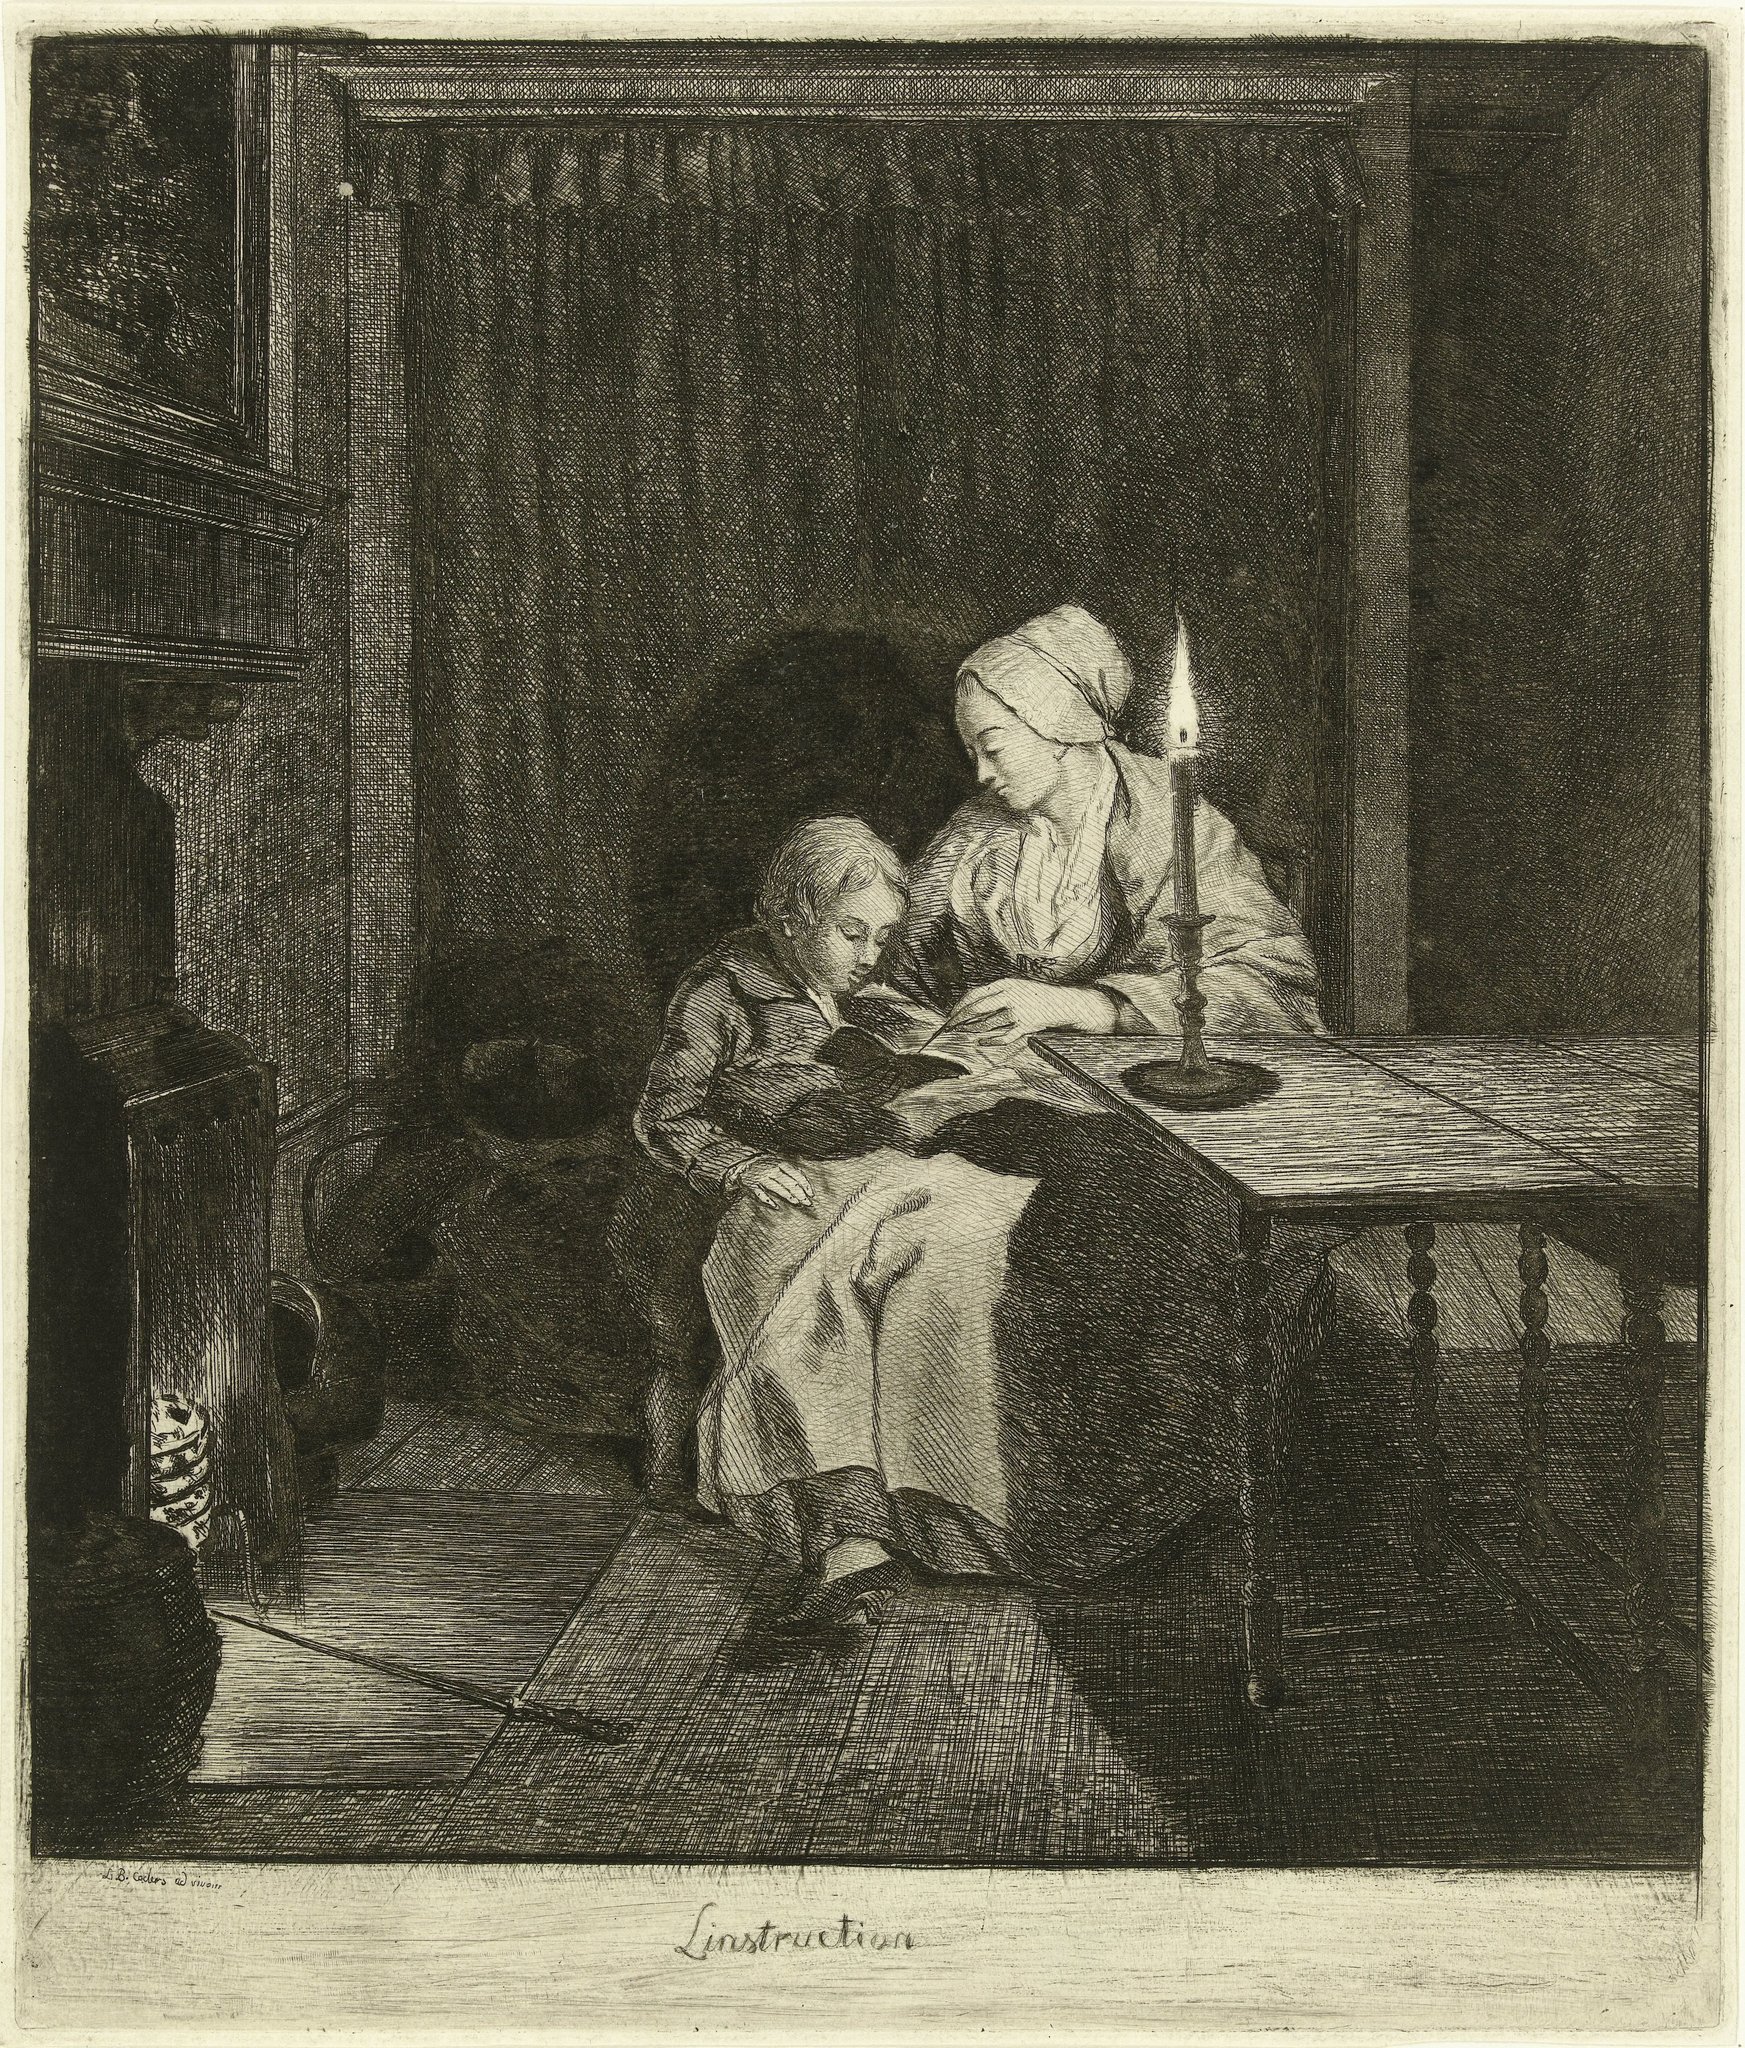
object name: print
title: Moeder geeft haar zoon les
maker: louis bernard coclers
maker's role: draughtsman, print maker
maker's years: 1741-1817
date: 1756-1817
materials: paper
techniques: etching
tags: mother and child(ren), woman and child(ren) (family group), teacher and pupil (+ lesson, lecture), child (at home)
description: In een huiskamer zit een moeder aan tafel. In haar hand houdt ze een boekje waaruit ze haar zoontje les geeft. De jongen staat naast haar en kijkt aandachtig naar het boek. Op tafel een kandelaar met een brandende kaars.